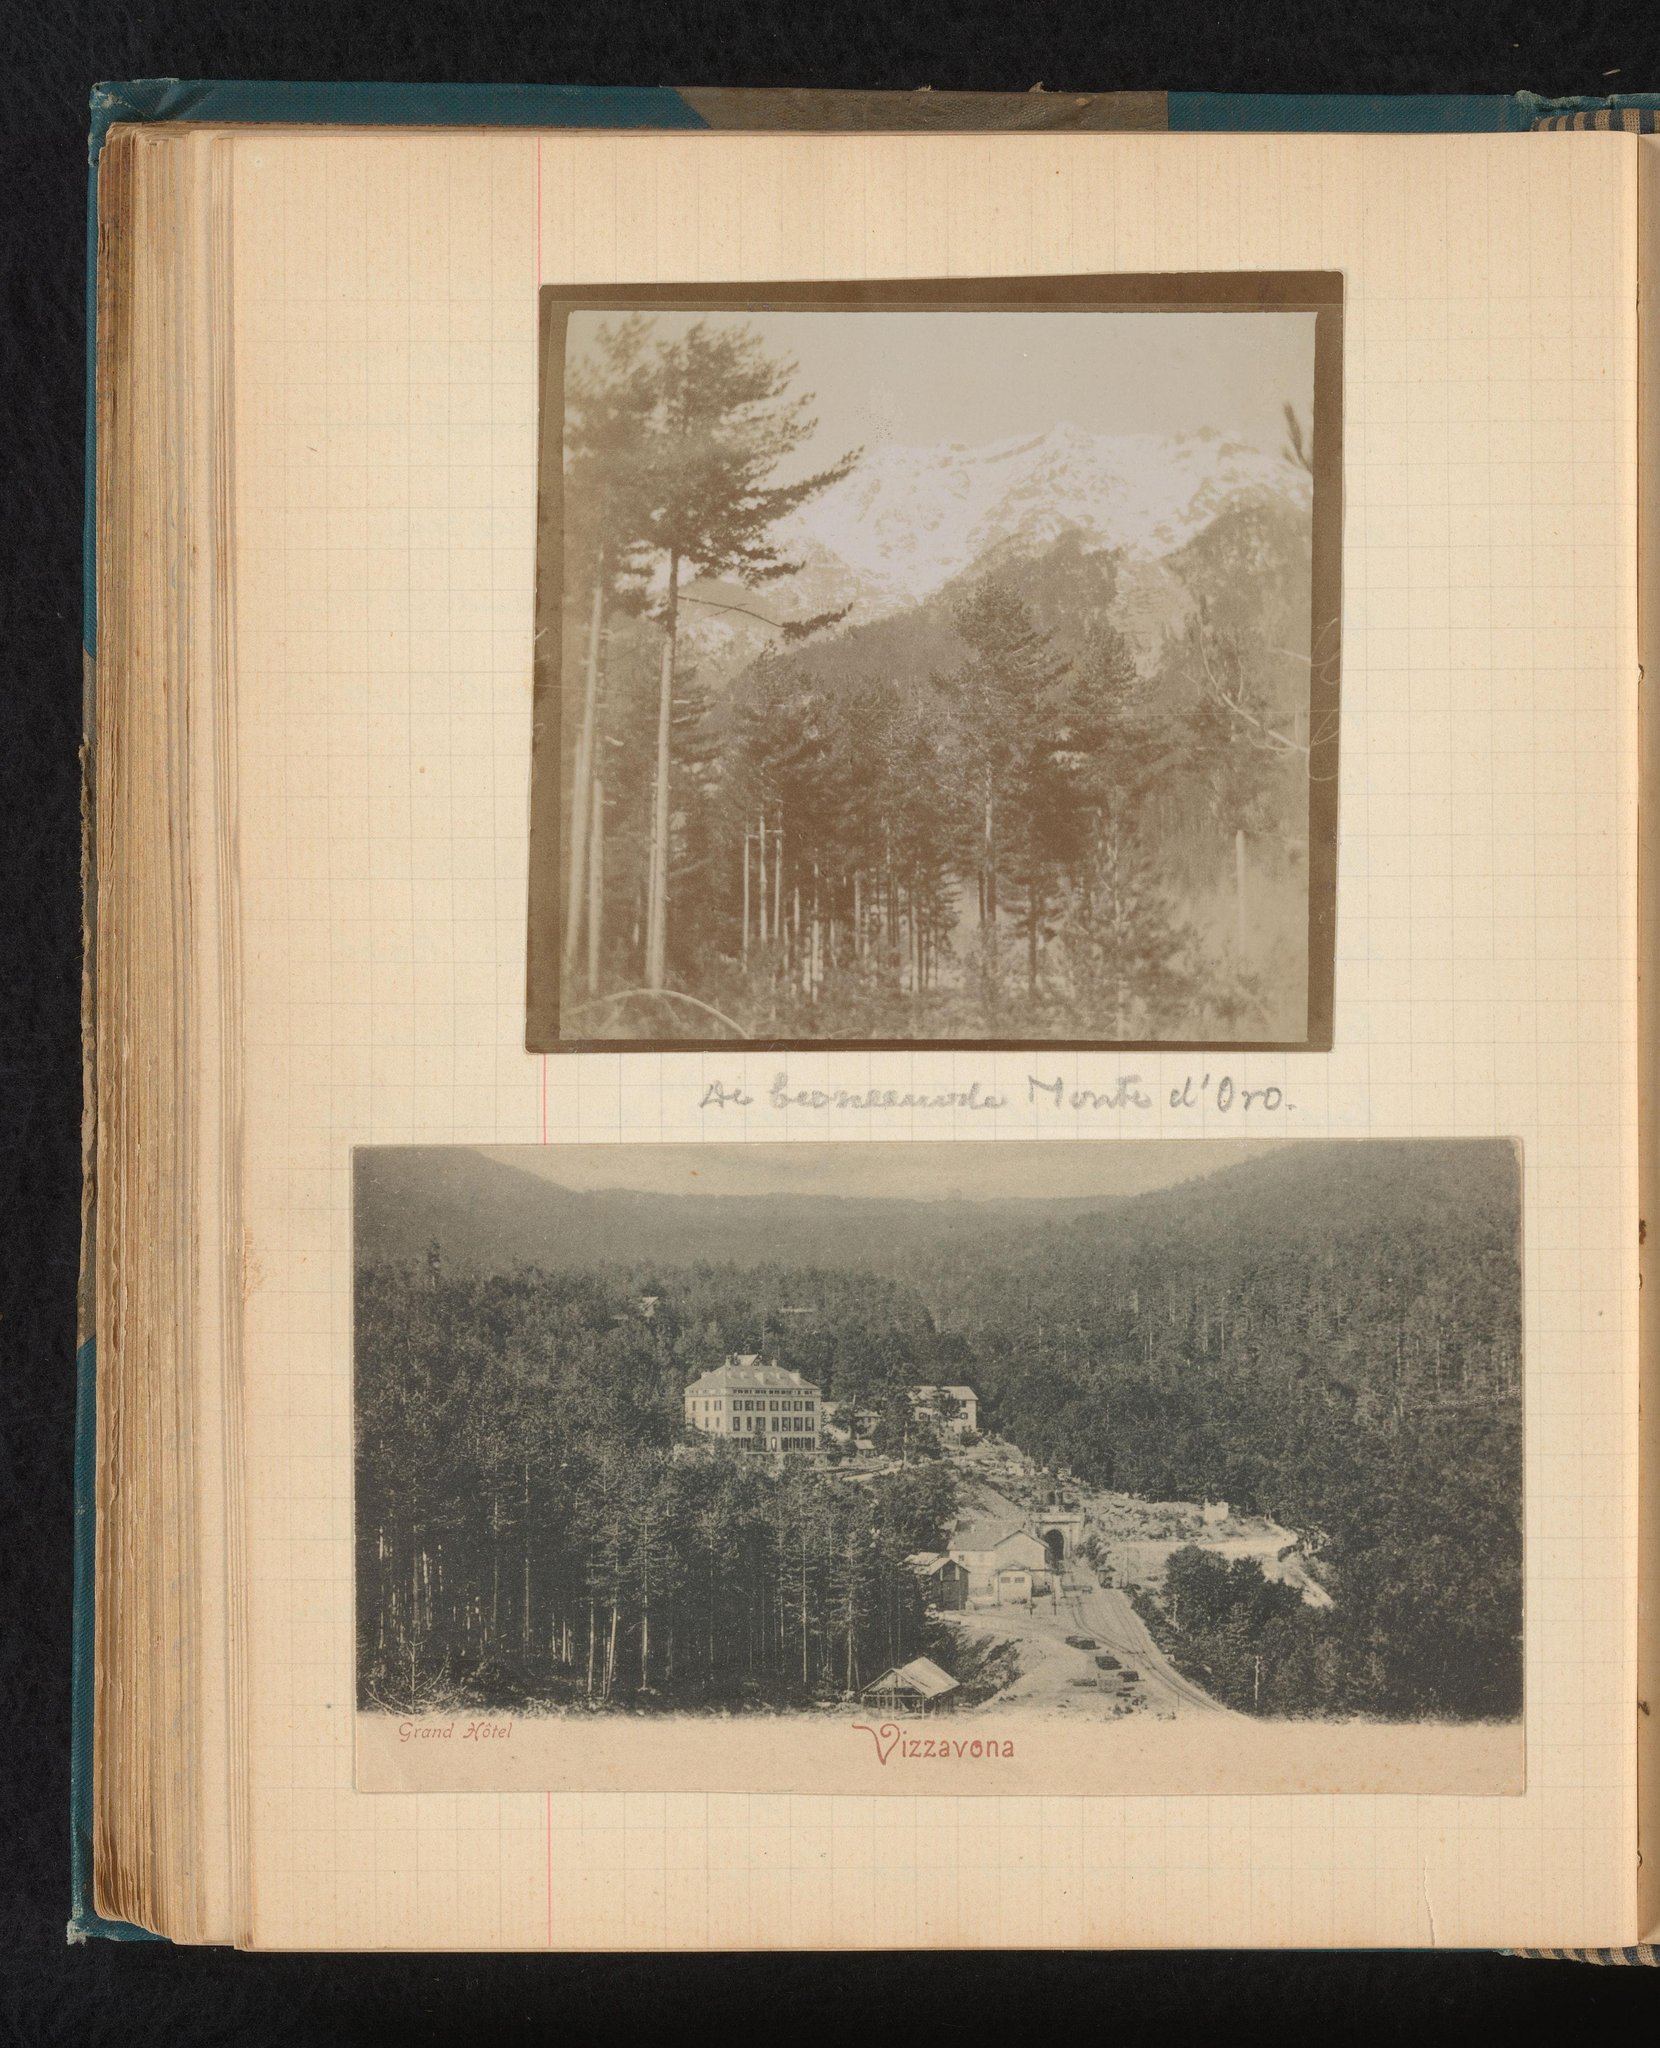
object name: ansichtkaart, prentbriefkaart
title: Gezicht op berg Monte d'Oro en het Grand Hotel in Vizzavona, Corsica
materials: paper, cardboard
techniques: photograph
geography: corsica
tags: forest of coniferous trees, mountain-range, snow peaks, hotel, hostelry, inn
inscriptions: inscription: ‘De besneeuwde Monte d'Oro’, inscription: ‘Grand Hotel/ Vizzavona’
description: Deze fotomechanische afdruk en foto maken deel uit van een album.